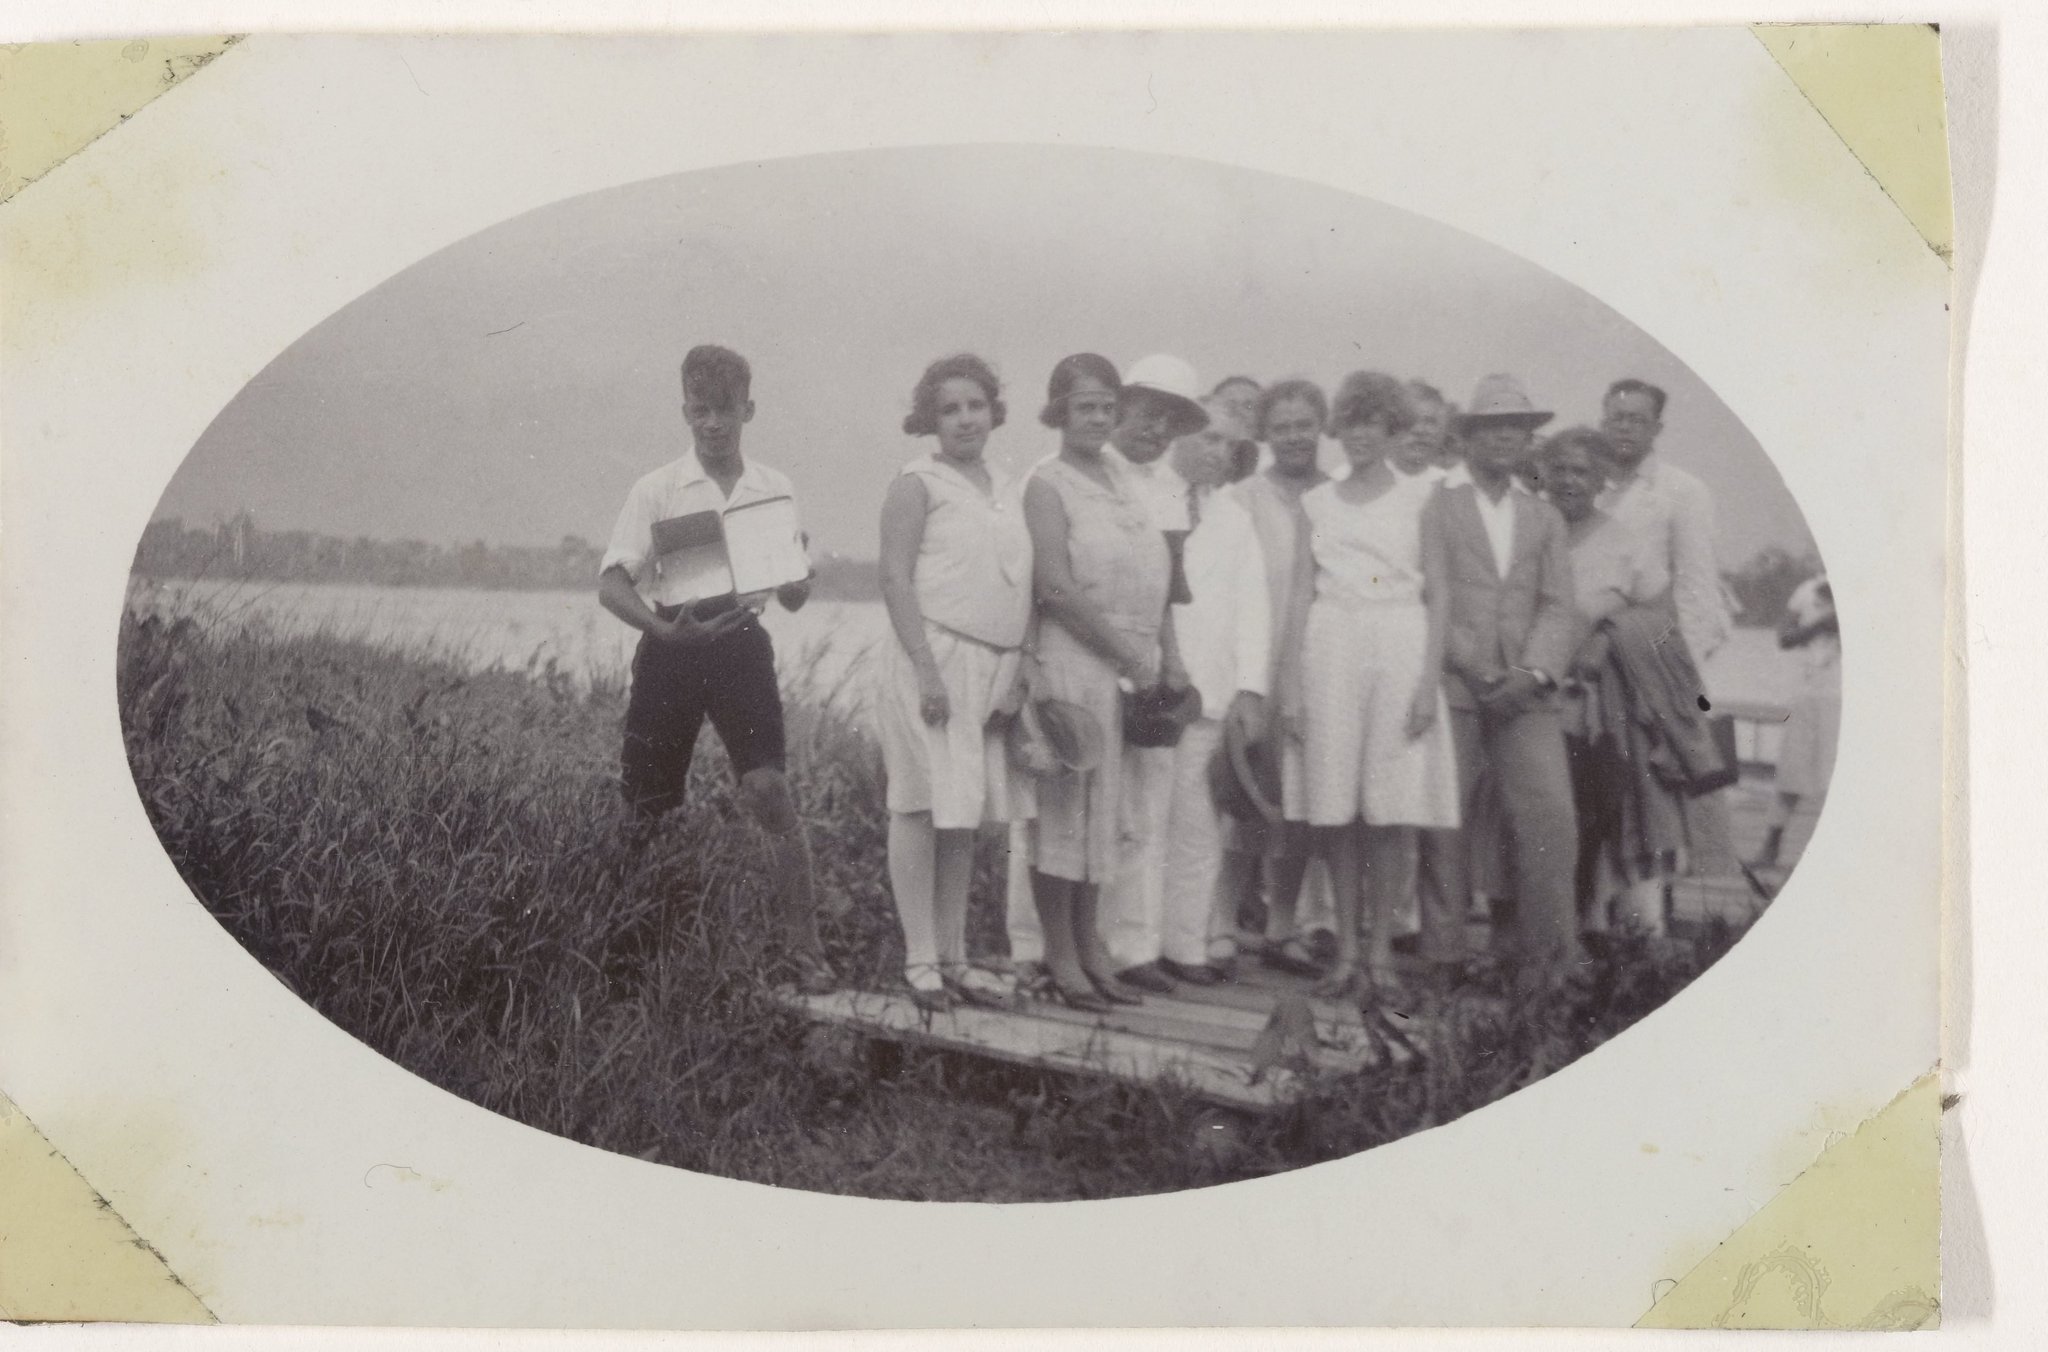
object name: photograph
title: Gezelschap bij de rivier op het terrein van plantage Accaribo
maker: theodoor brouwers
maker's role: amateurfotograaf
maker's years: 1874-1932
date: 1931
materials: photographic support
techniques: photography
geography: suriname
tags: amsterdam, theodoor brouwers, suriname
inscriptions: inscription: ‘Accaribo Mei "31’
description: In de periode 1911-1932 woonde op plantage Accaribo in Suriname de familie Brouwers van wie de foto's afkomstig zijn. Rond 1910 vond Theodoor Brouwers werk op plantage Accaribo. In 1929 werd hij eigenaar van de plantage.